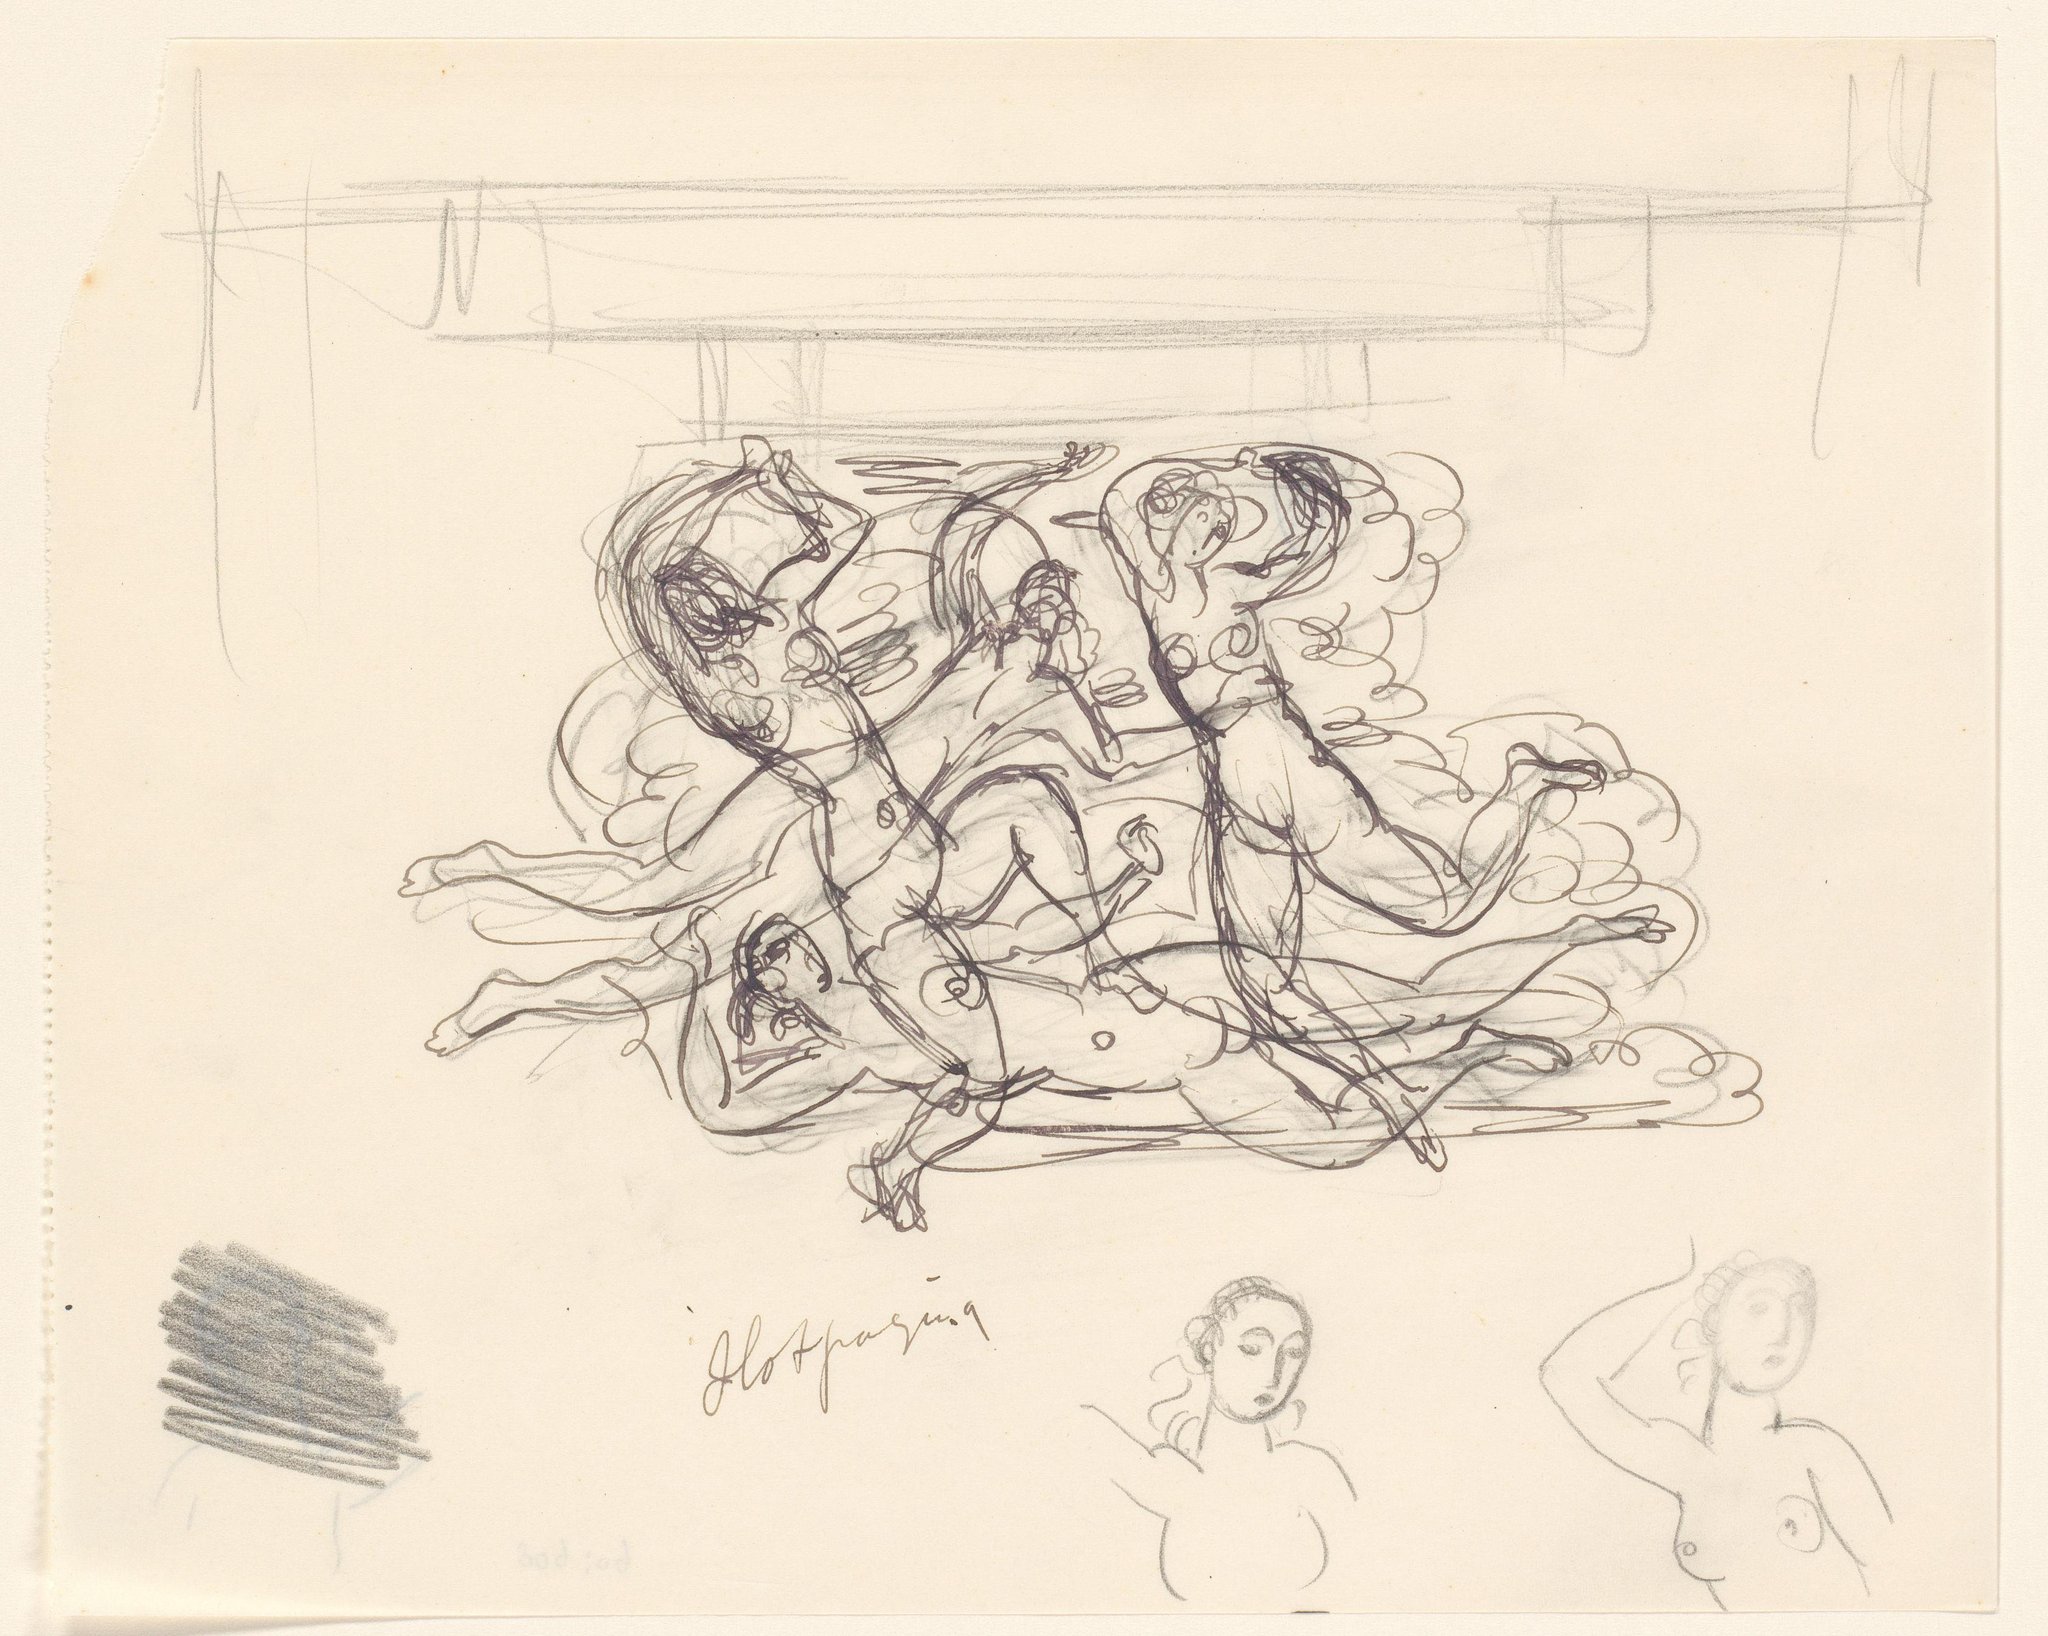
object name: drawing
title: Naakte vrouwen, zwemmend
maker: leo gestel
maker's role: draughtsman, print maker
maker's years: 1881-1941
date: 1891-1941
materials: ink, paper, pencil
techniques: pen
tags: swimming (movement in water) - aa - female human figure (+ nude human being)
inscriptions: watermark: ‘GW/ papier/ 1671’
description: Rechtsonder twee bovenlichamen van vrouwen.